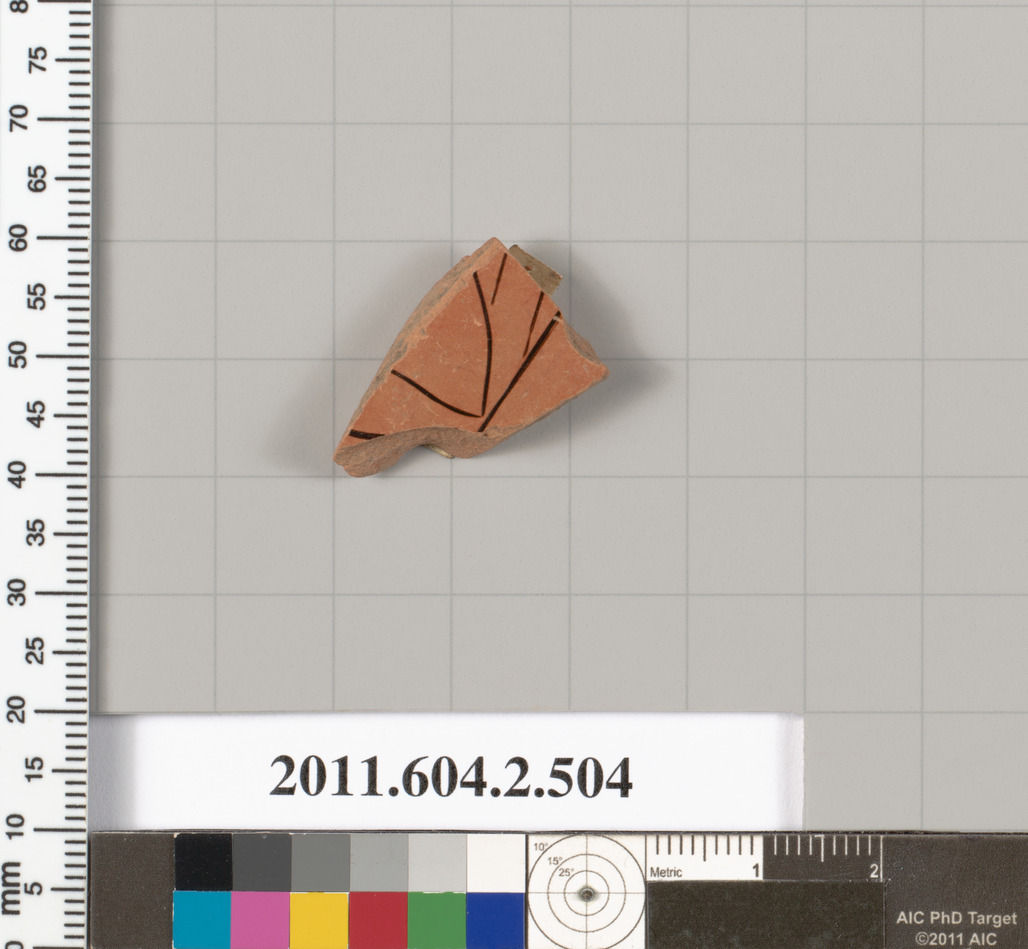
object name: column krater fragment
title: Terracotta fragment of a column-krater (bowl for mixing wine and water)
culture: greek, attic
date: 475-451 BCE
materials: terracotta